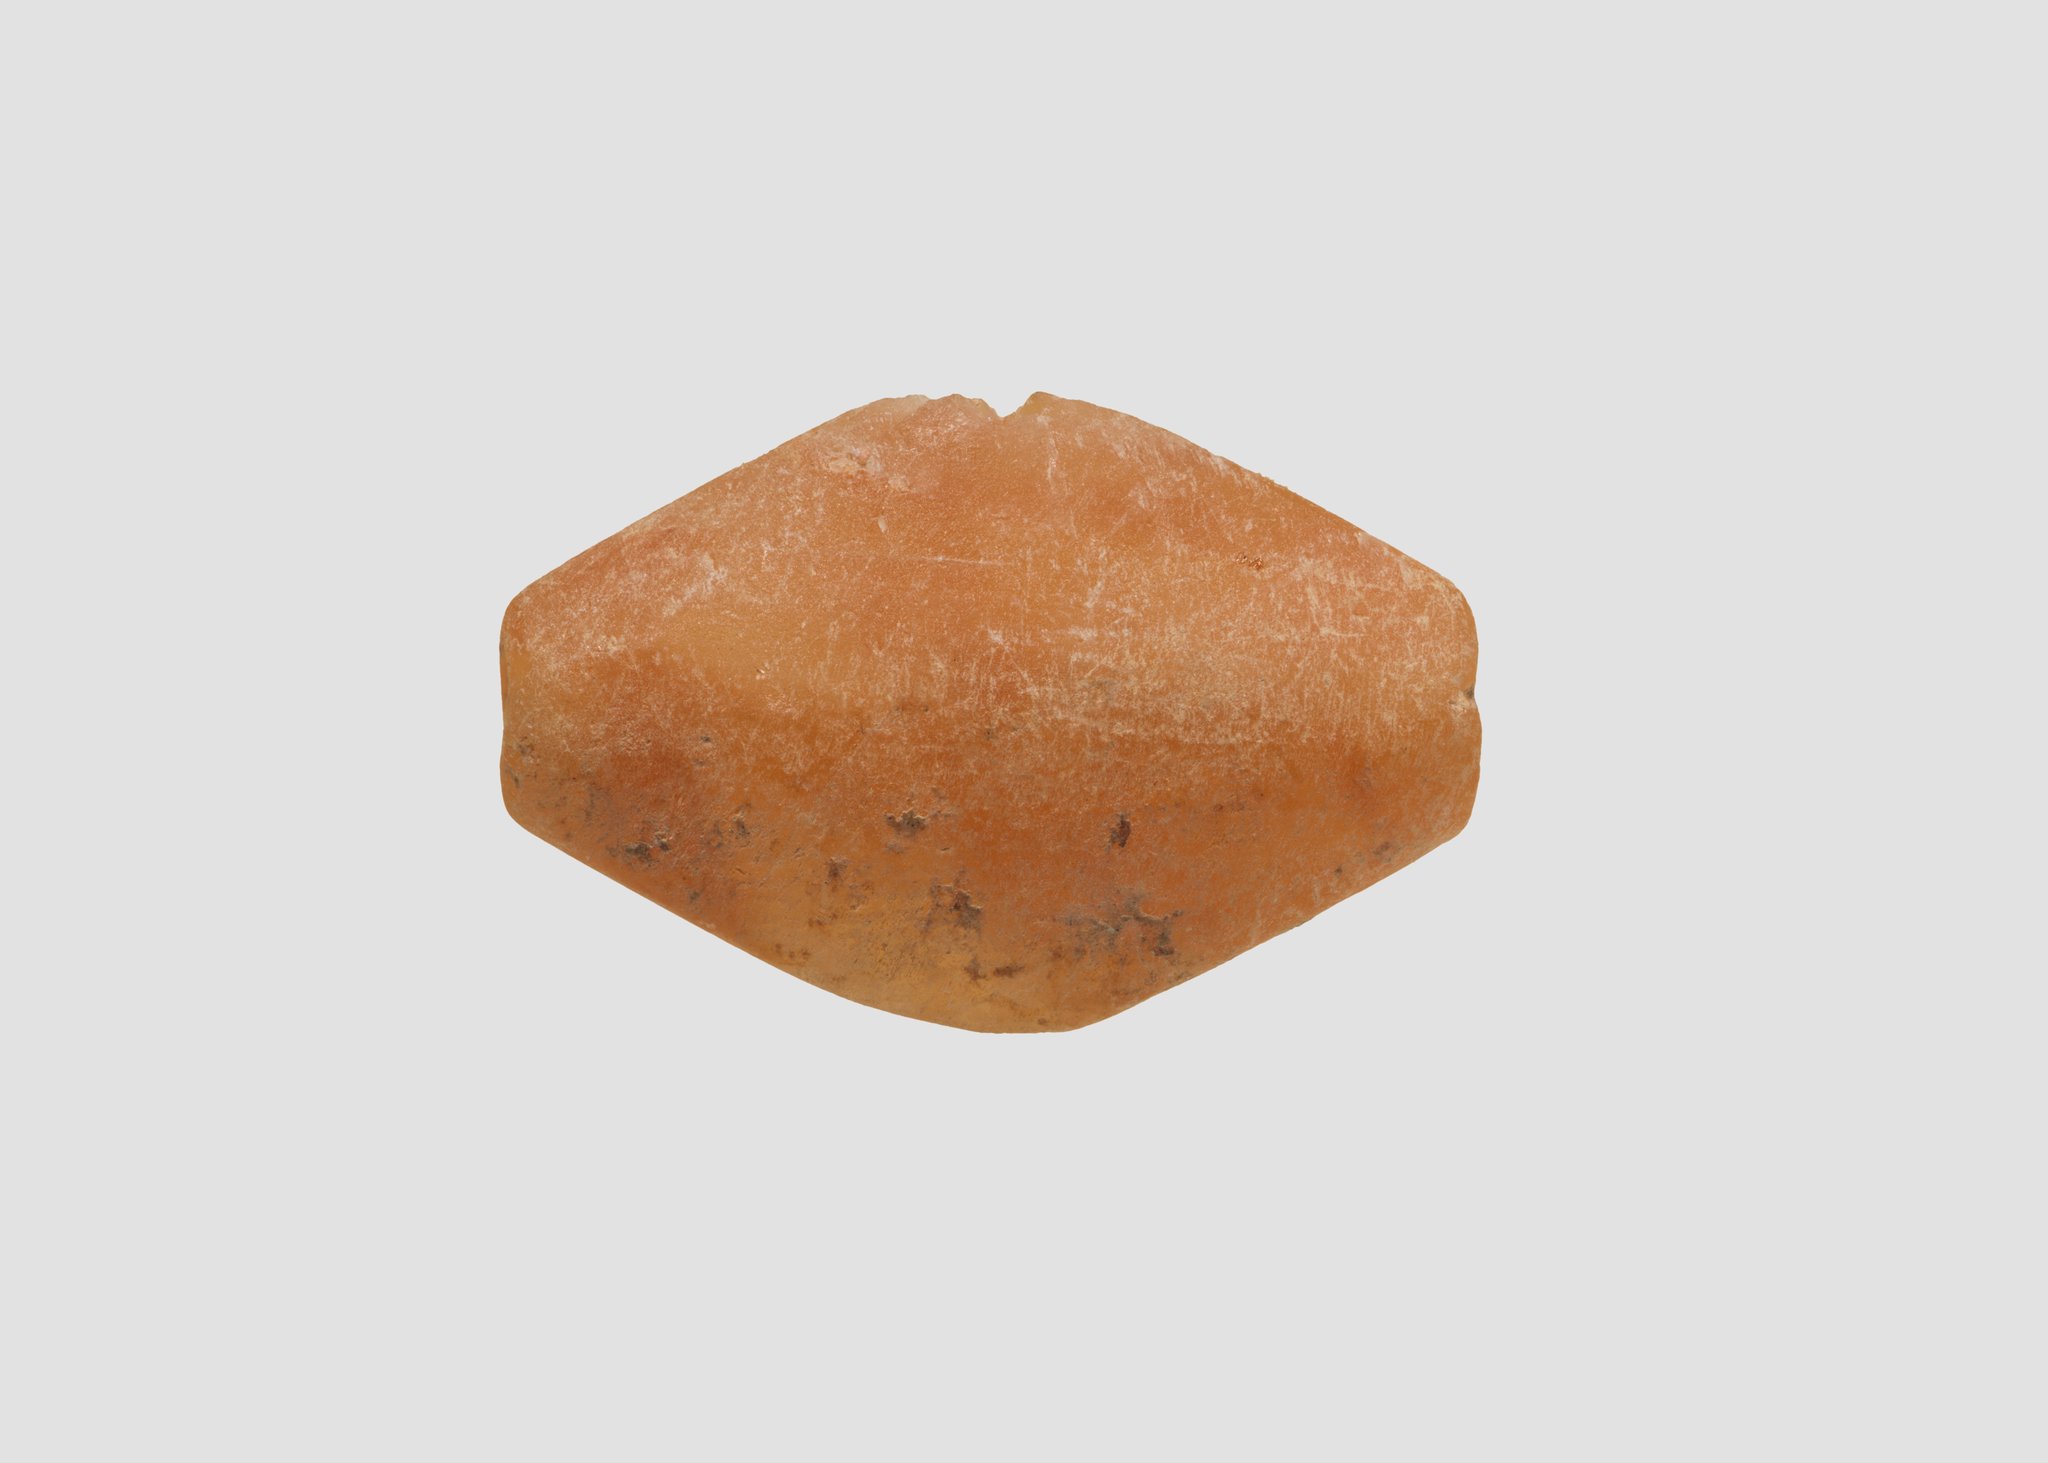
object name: bead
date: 7333-7001 BCE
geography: syria